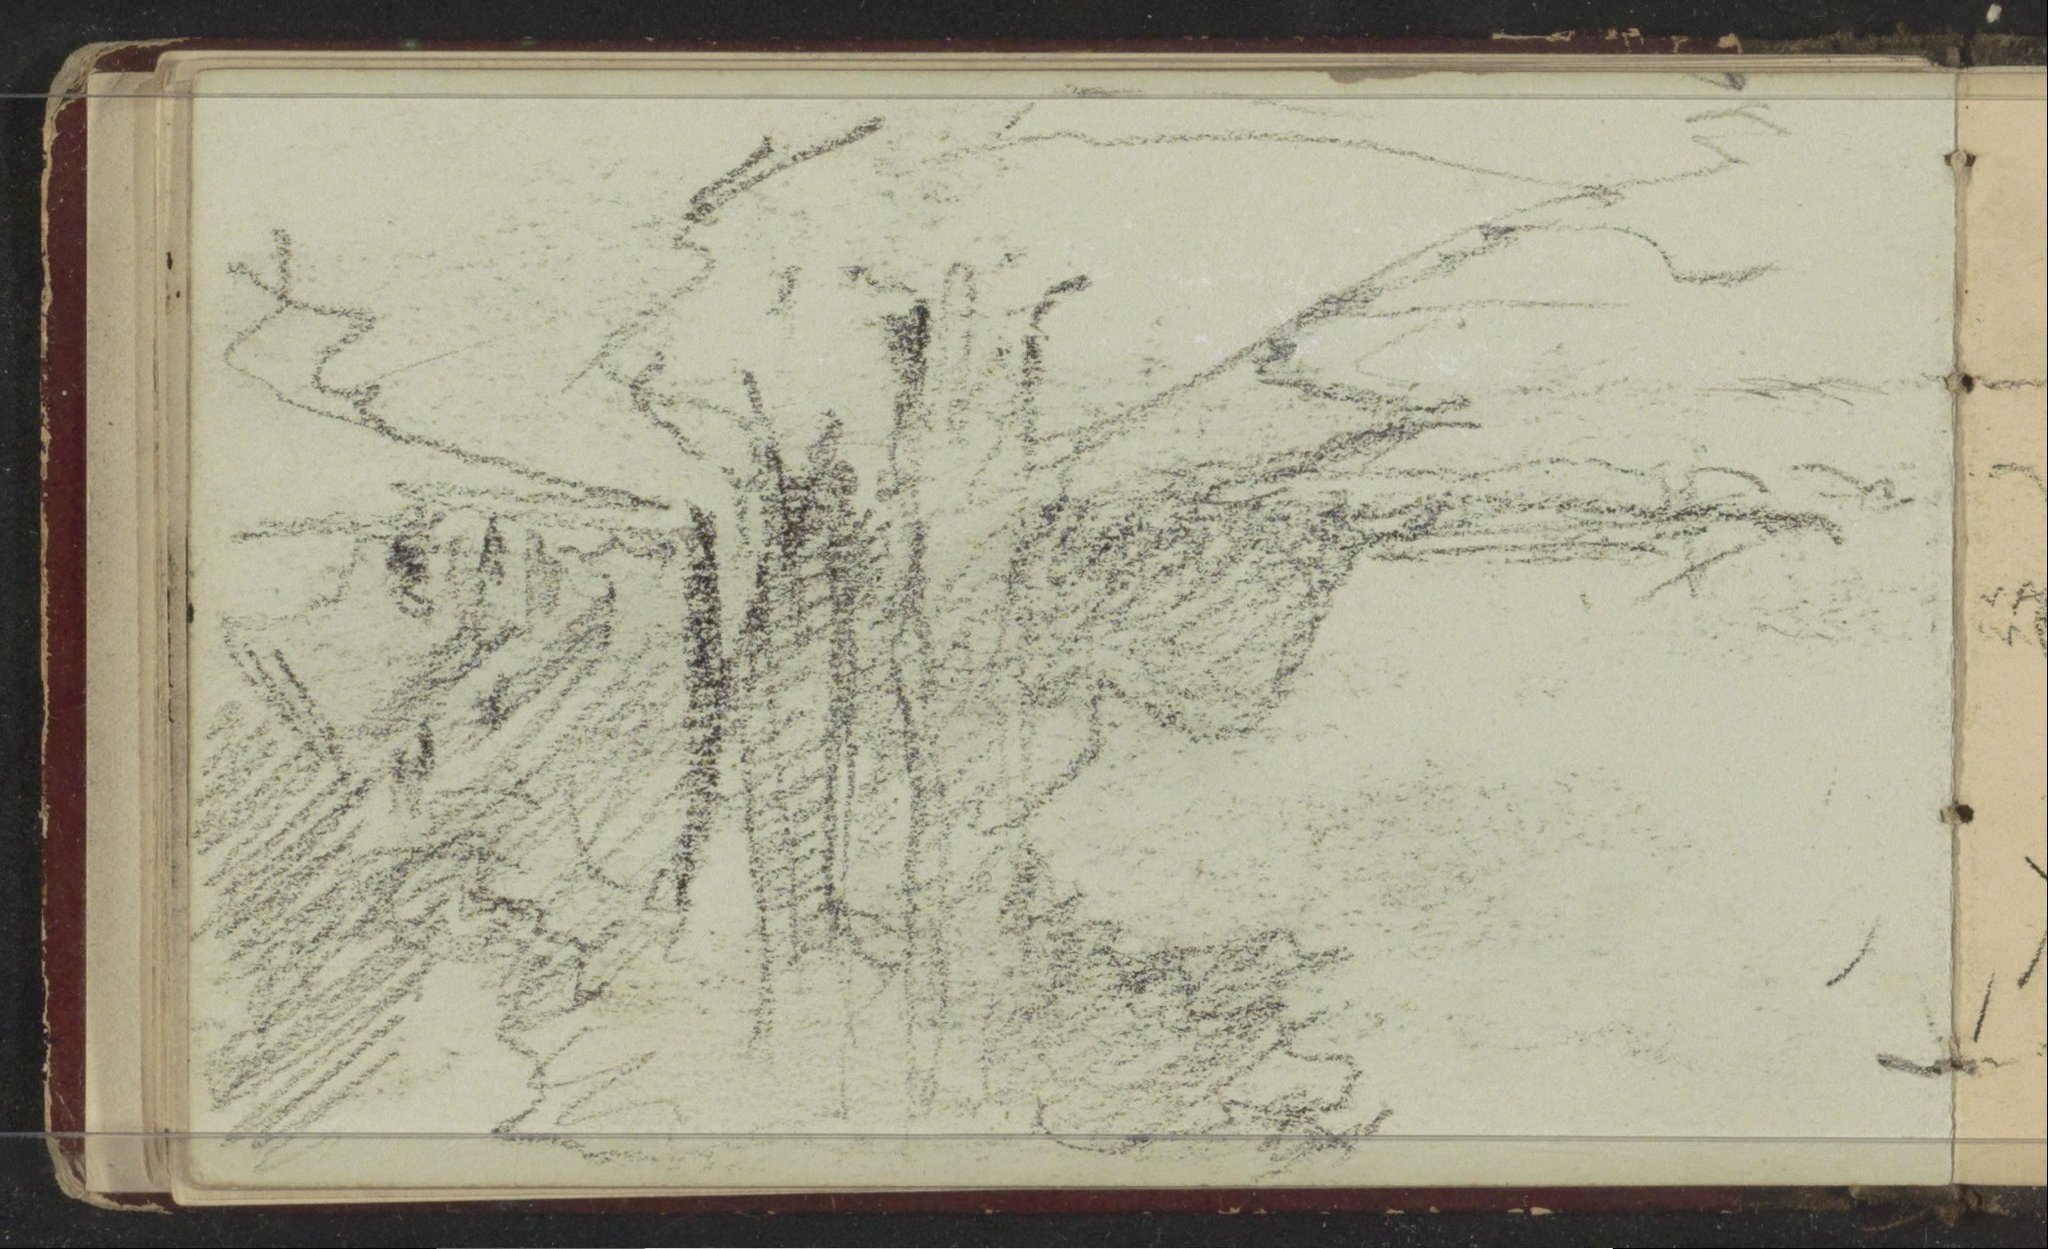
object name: sketchbook leaf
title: Bomenlaan langs een waterkant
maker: willem cornelis rip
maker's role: draughtsman, painter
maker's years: 1856-1922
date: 1891-1892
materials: chalk, paper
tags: landscapes with waters, waterscapes, seascapes (in the temperate zone), road, path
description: Blad 26 verso uit een schetsboek met 28 bladen.